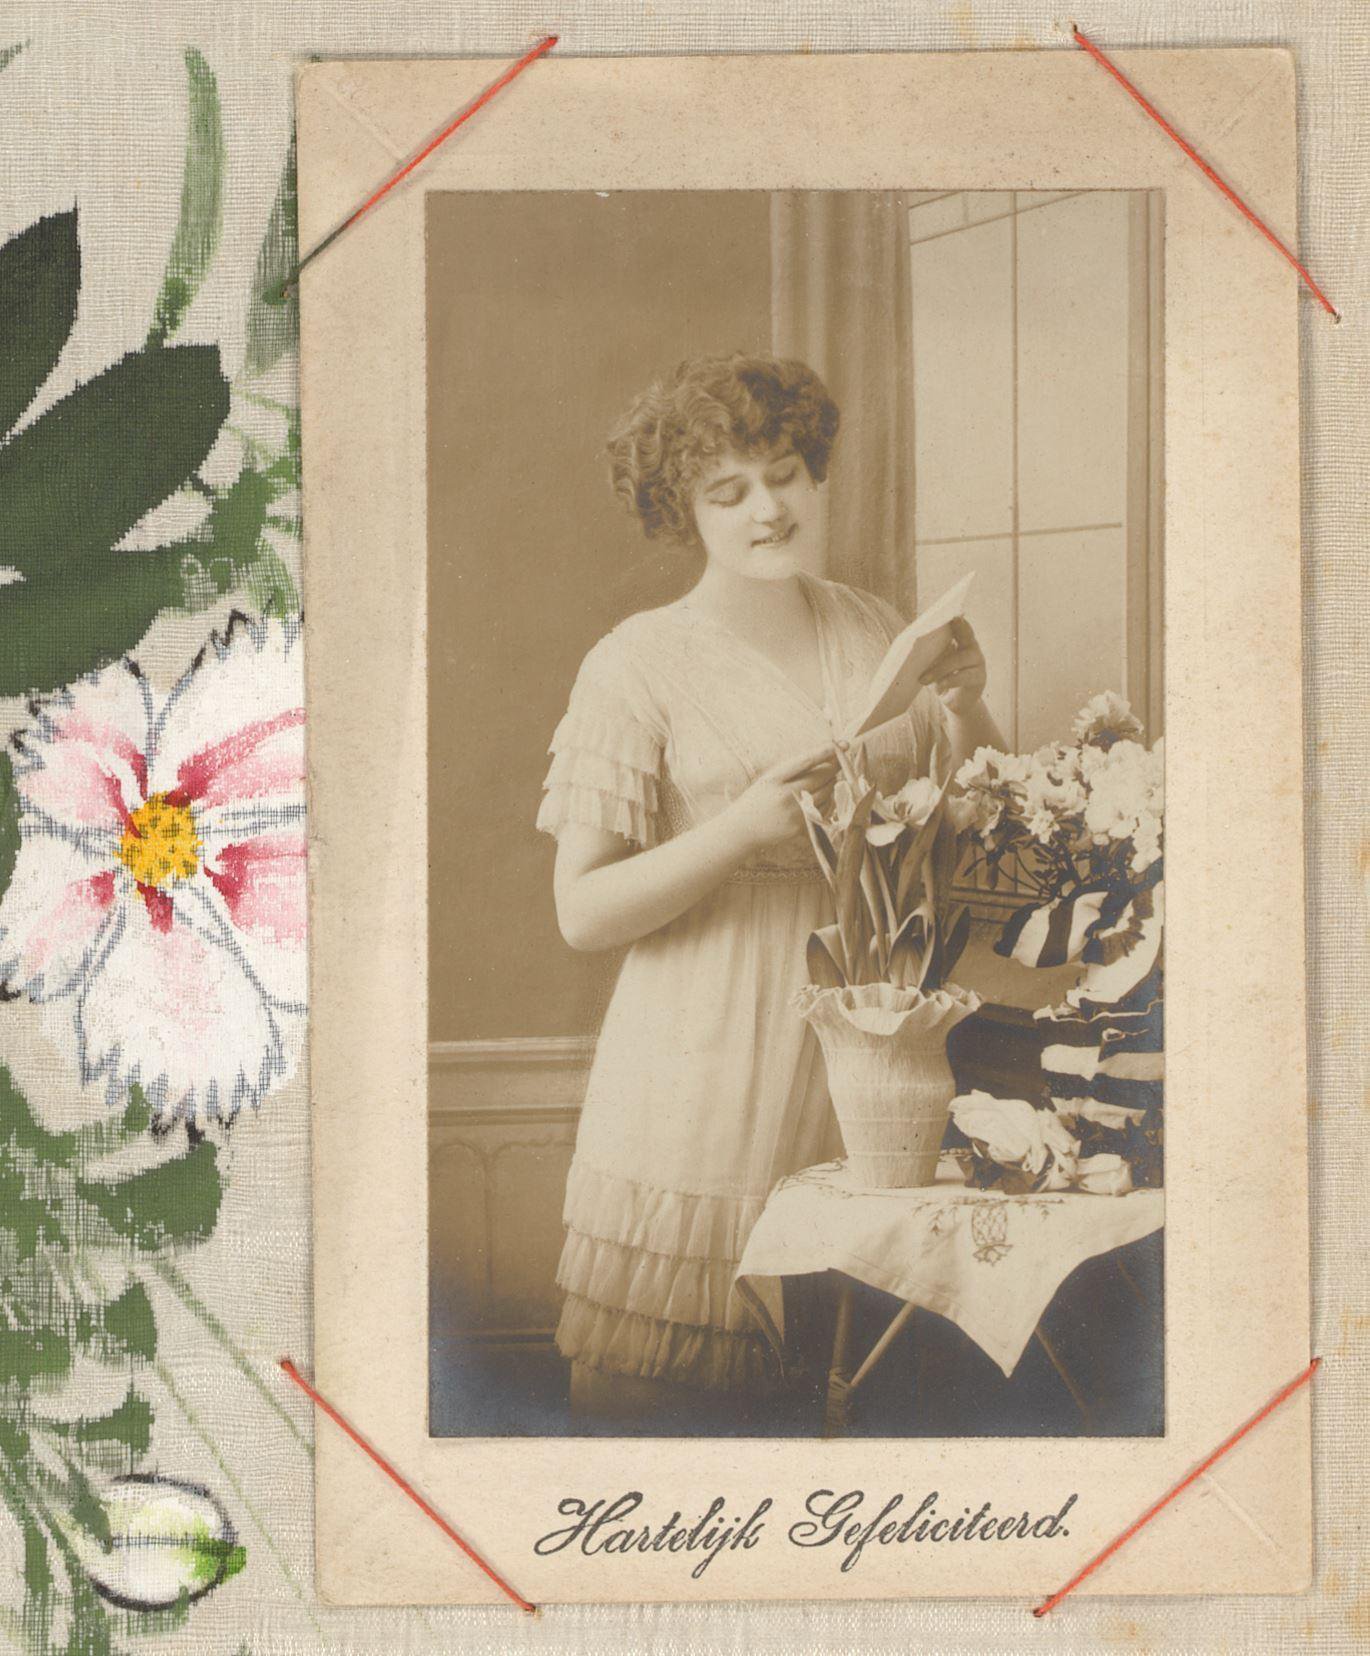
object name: ansichtkaart, prentbriefkaart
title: Portret van een vrouw met een envelop in de hand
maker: Anonymous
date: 1880-1920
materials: paint, photographic support, silk, textile, watercolor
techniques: brush, gelatin silver print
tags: adult woman, historical persons, letter, envelope